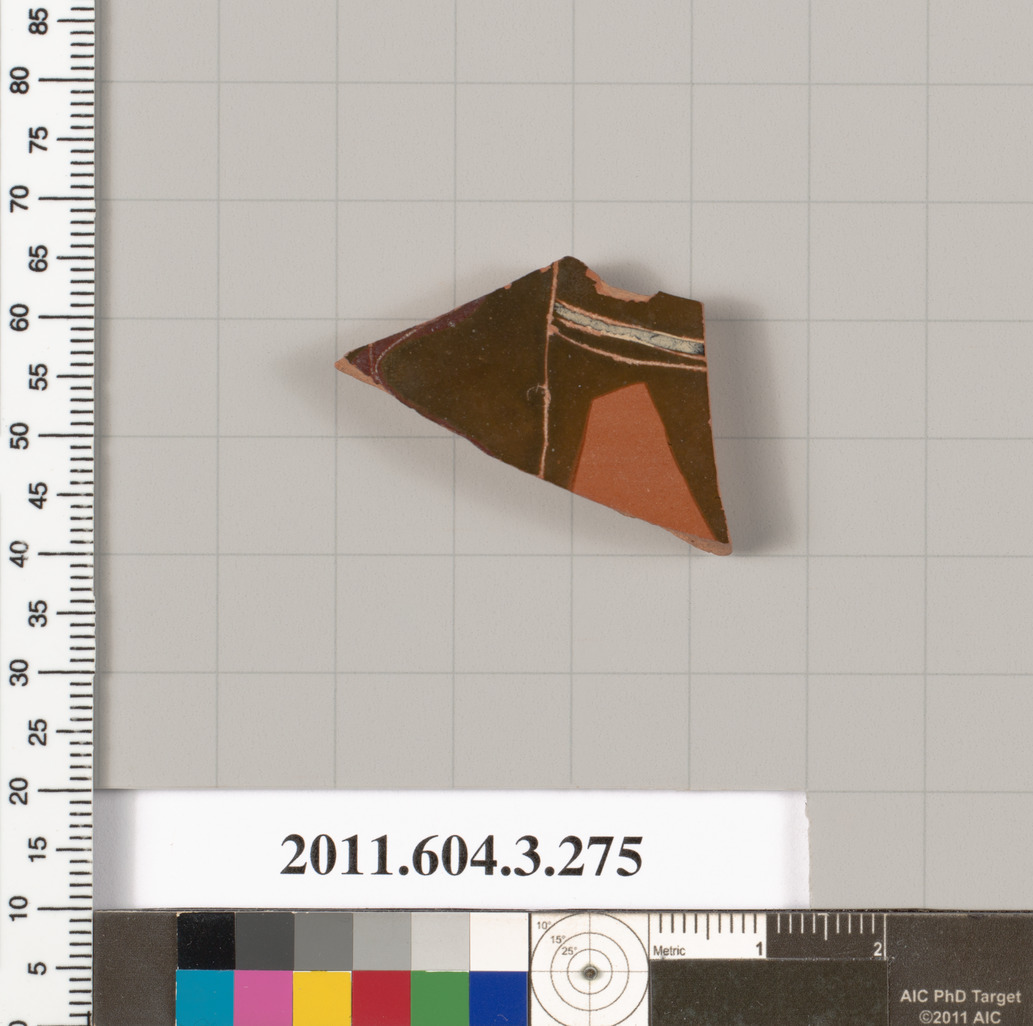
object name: neck amphora fragment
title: Terracotta fragment of a neck-amphora (jar)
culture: greek, attic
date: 534-468 BCE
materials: terracotta